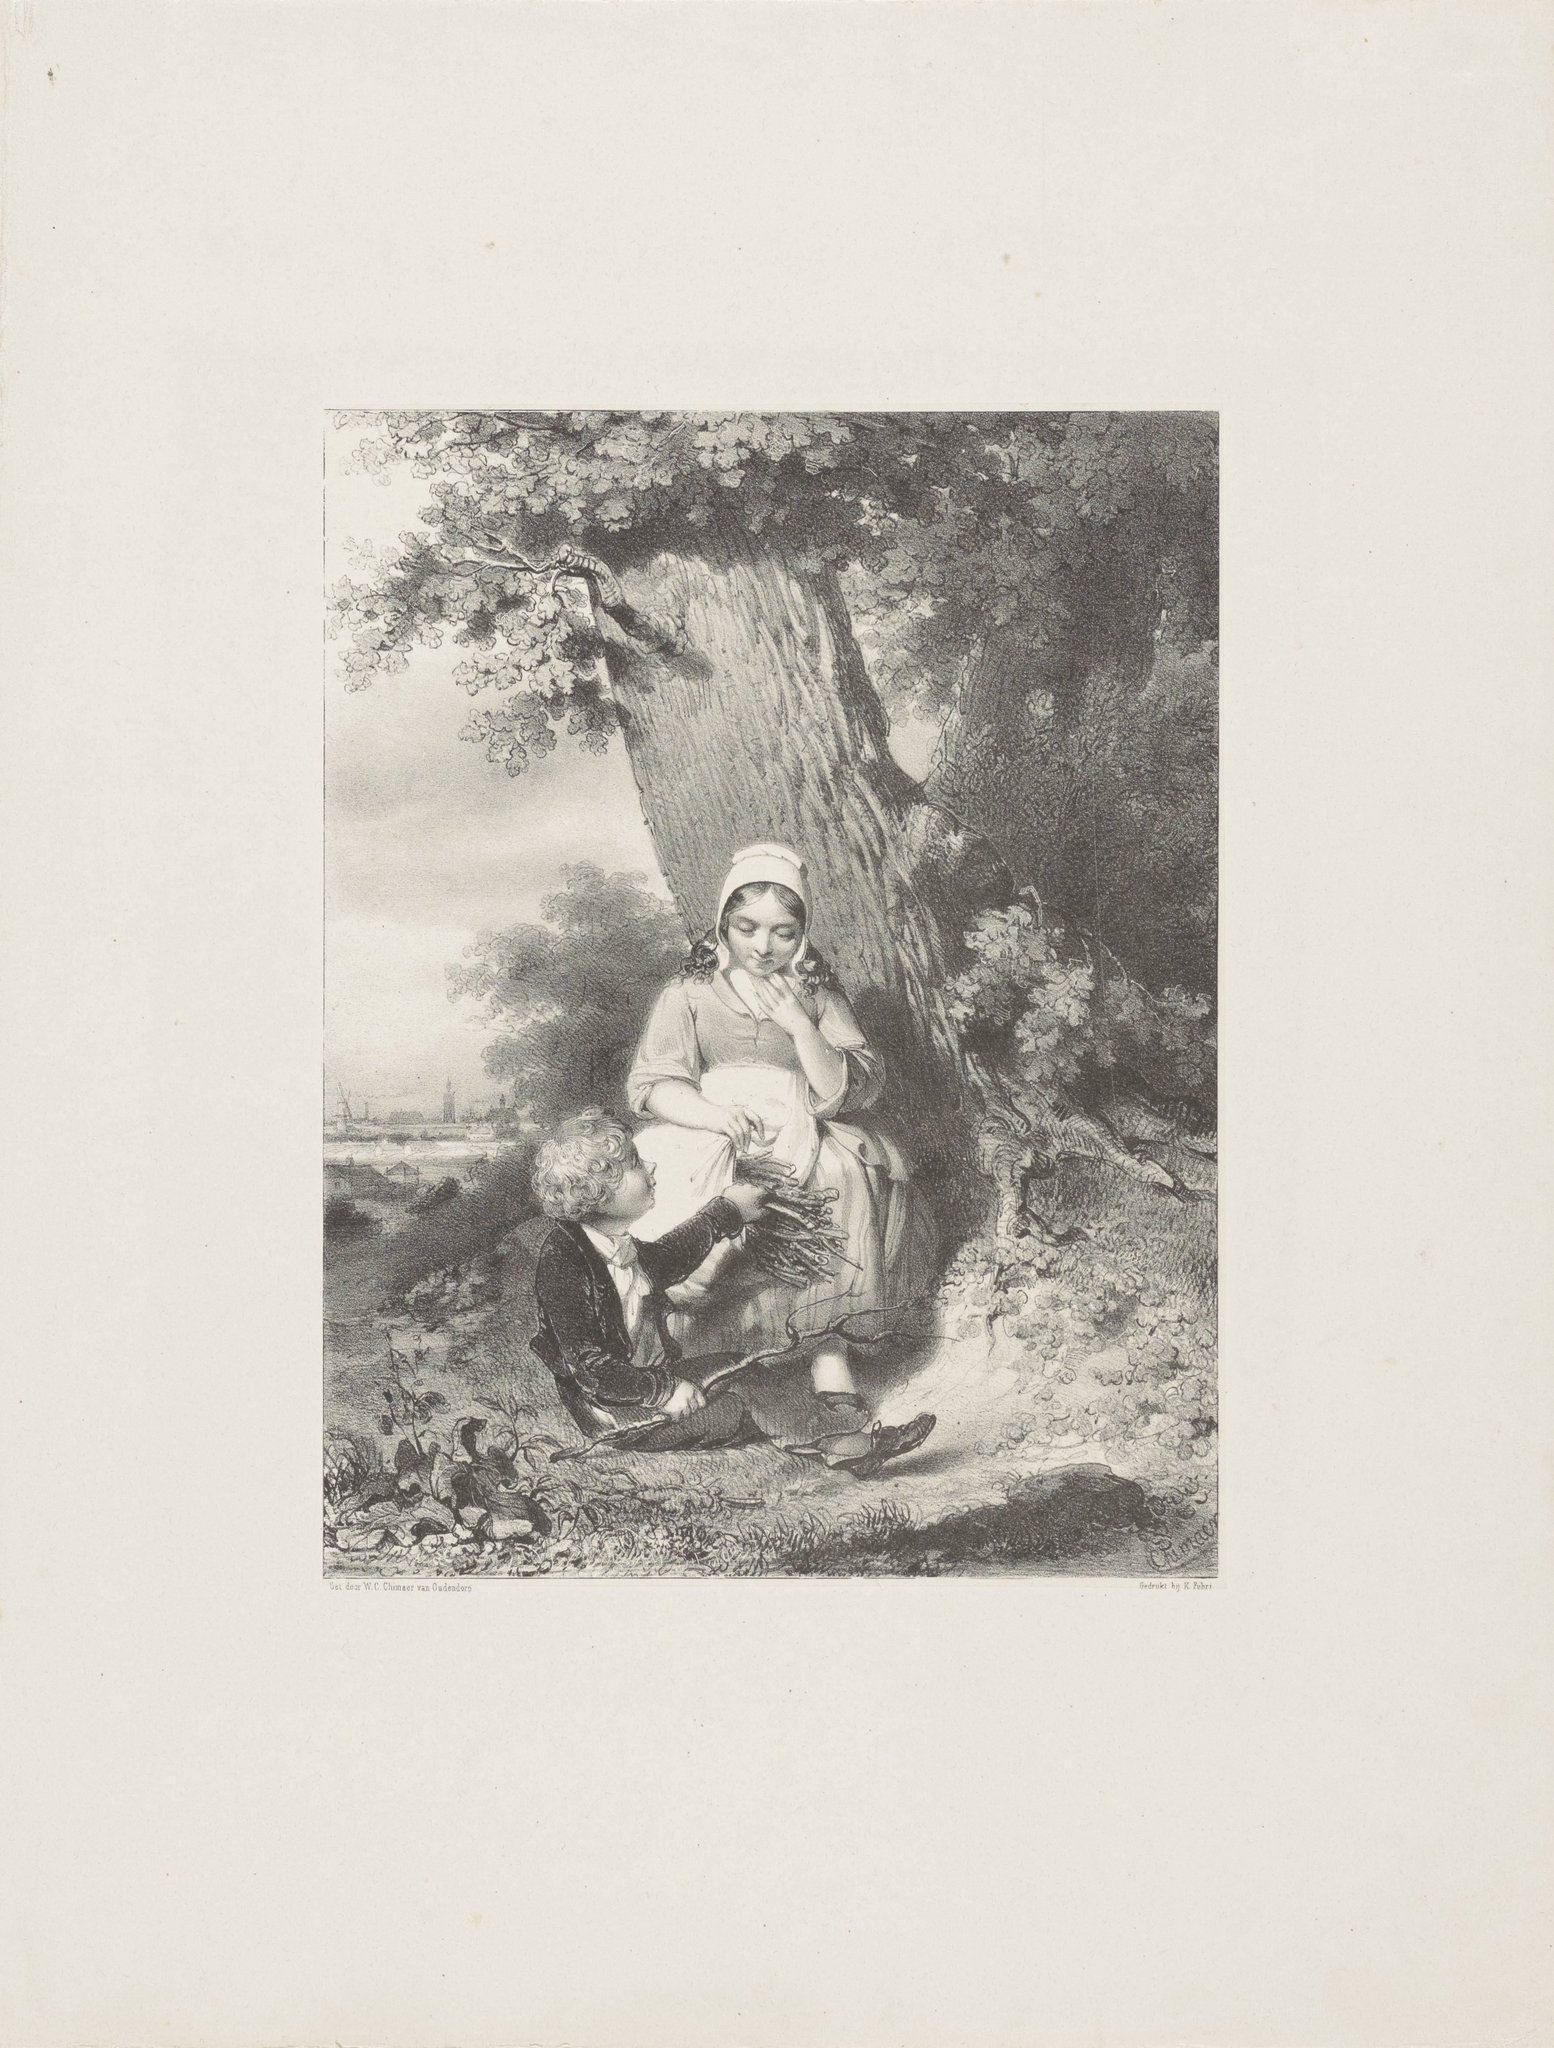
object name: print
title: Meisje en jongen met een bos takken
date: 1837-1853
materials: paper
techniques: lithograph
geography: netherlands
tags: prospect of village, silhouette of village, twigs ~ building material, forest, wood, child (+ two persons), sitting on the ground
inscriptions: collector's mark: Lugt 2228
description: Het meisje heeft een bos takken in haar schort. De jongen trekt er een uit. In zijn rechterhand heeft hij een lange tak. Verderop een boerderij met hooischuur en een dorp met molen en kerktoren.